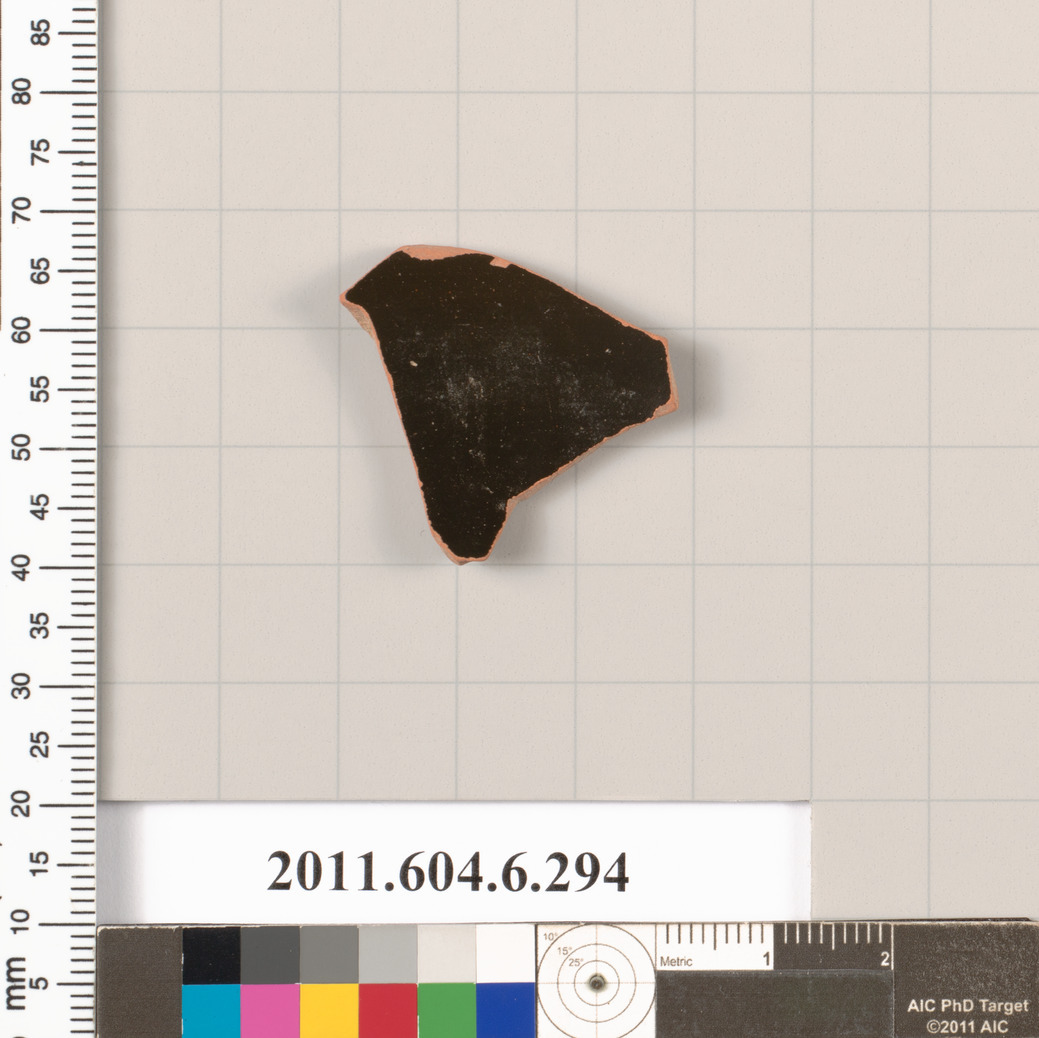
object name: undetermined open shape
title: Terracotta fragment of an open shape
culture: greek, attic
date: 367-335 BCE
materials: terracotta